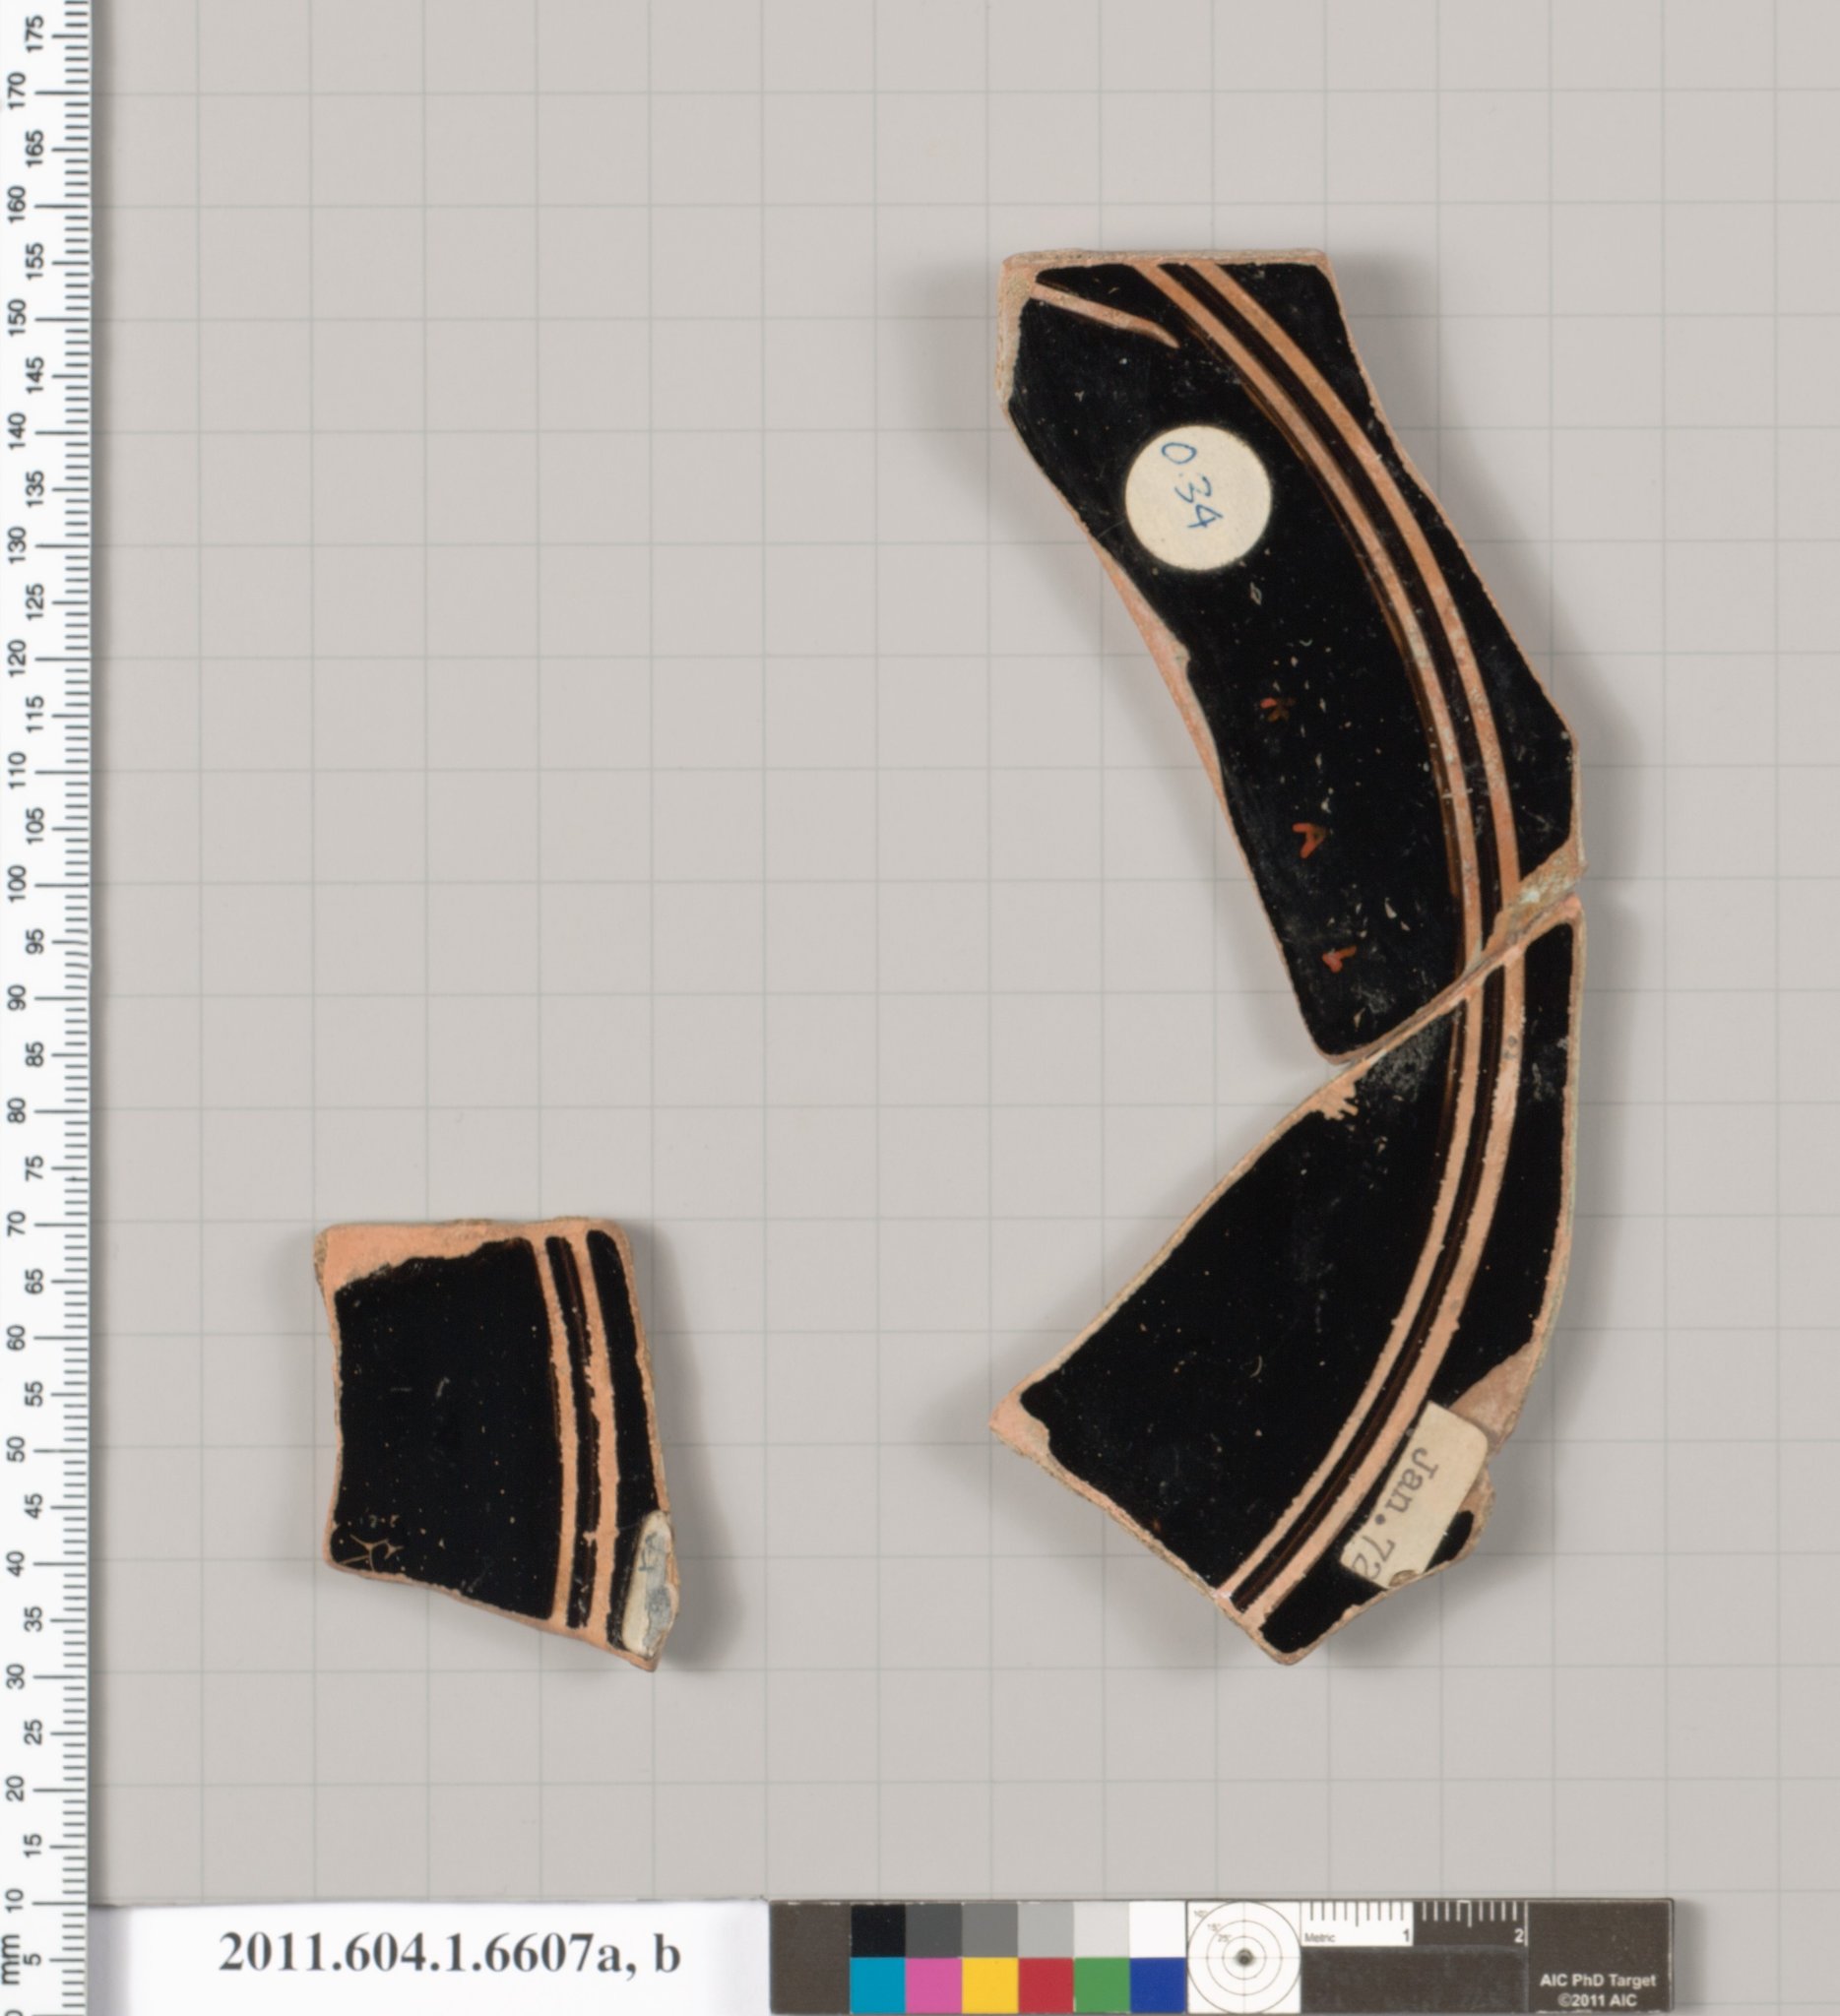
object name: kylix fragment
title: Terracotta fragments of a kylix (drinking cup)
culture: greek, attic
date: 490-480 BCE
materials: terracotta